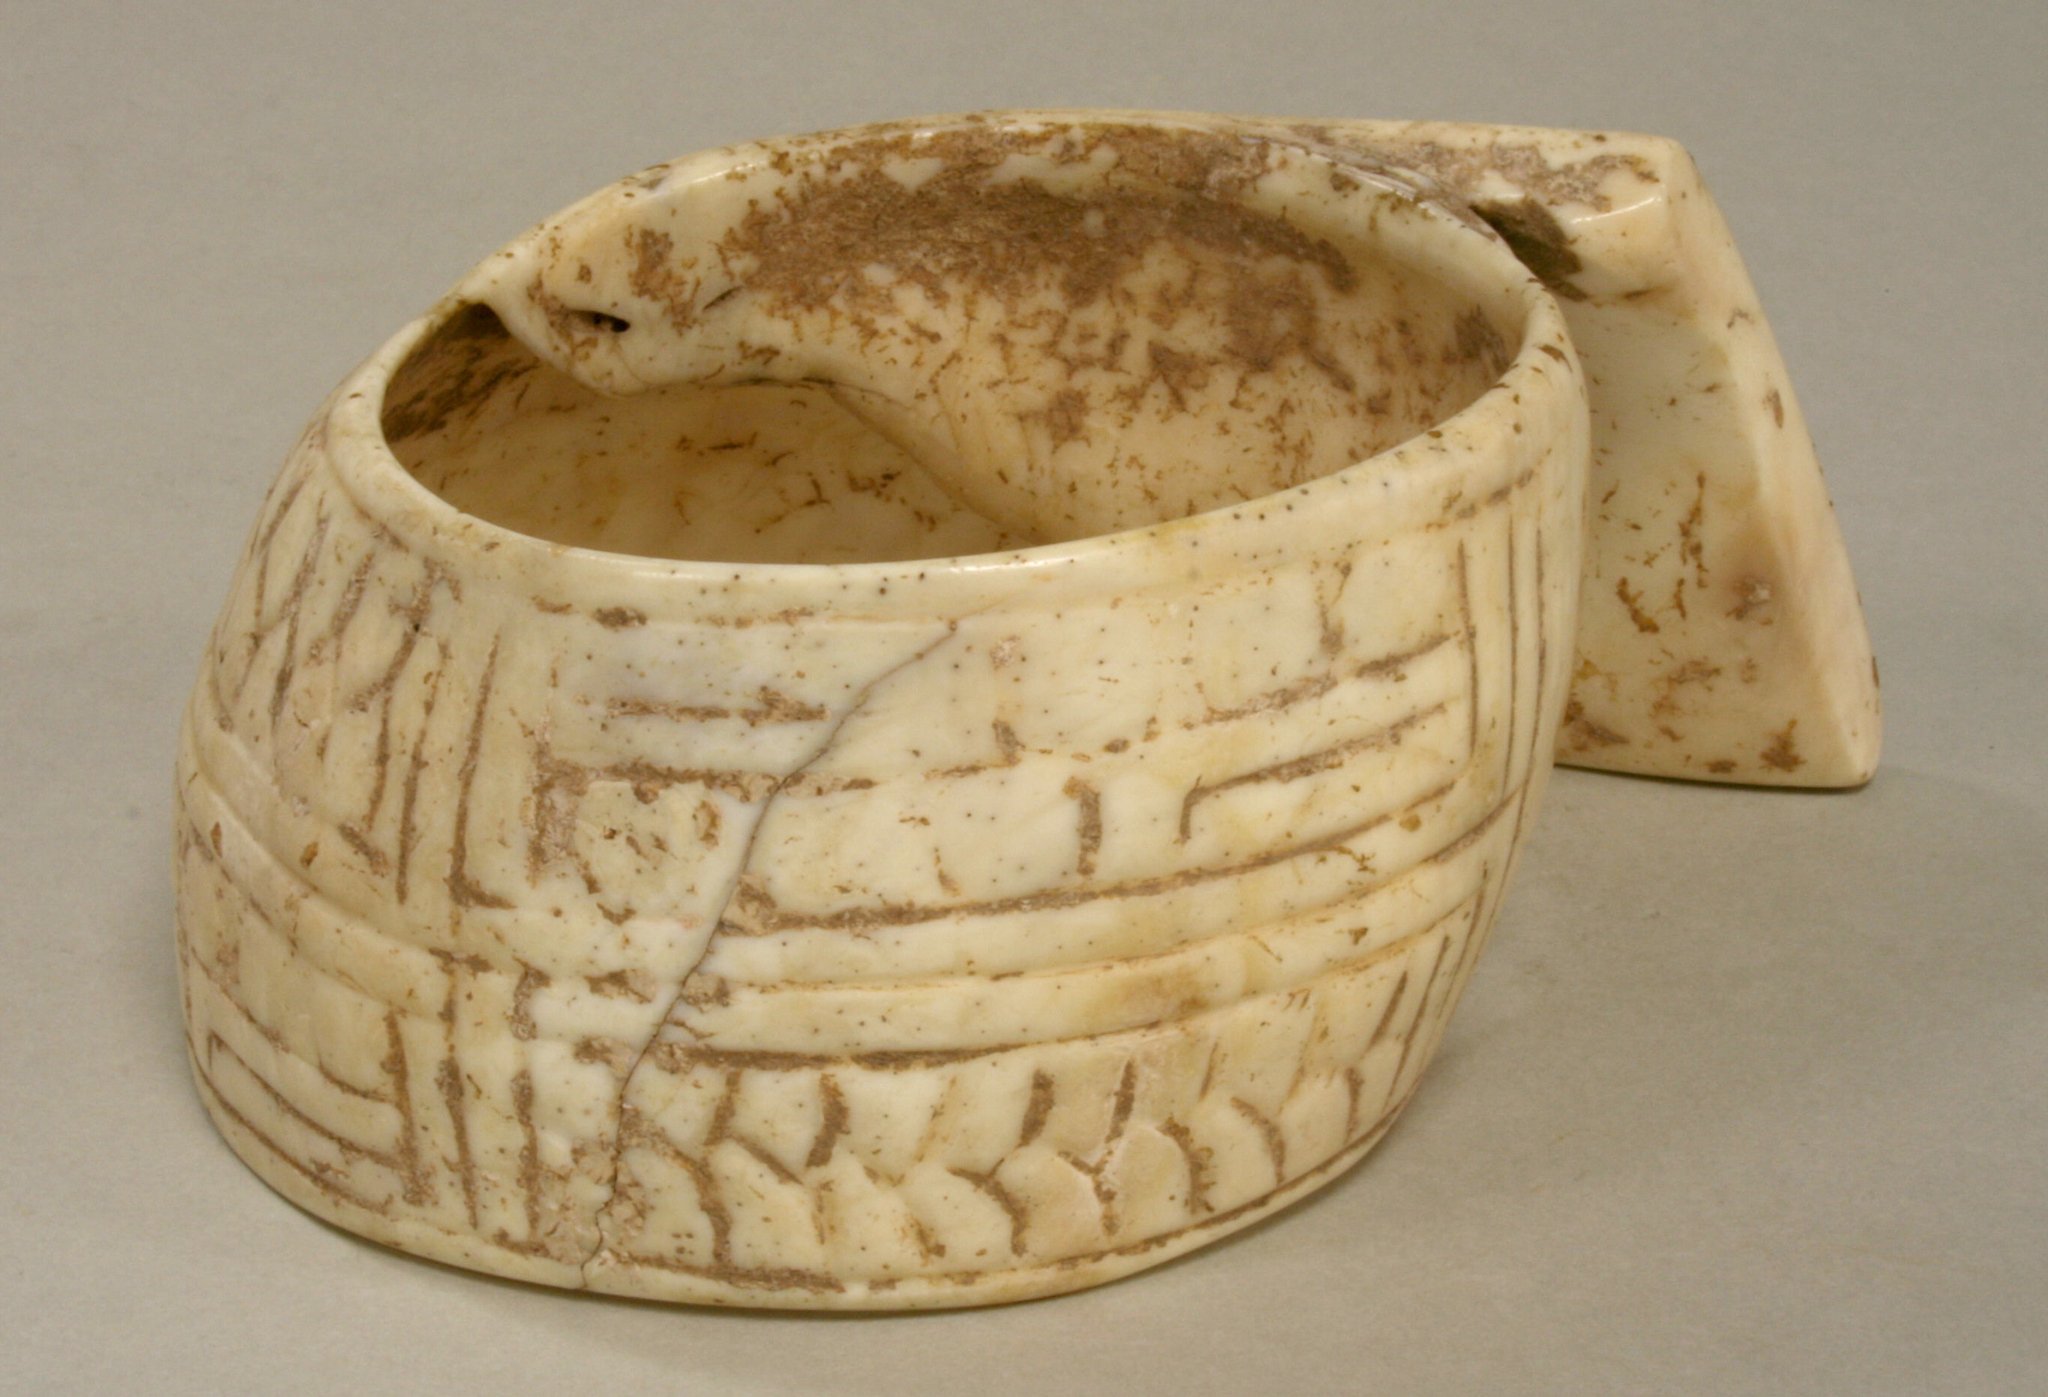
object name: armband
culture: huastec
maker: huastec artist(s)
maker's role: artist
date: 900-1300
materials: shell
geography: mexico